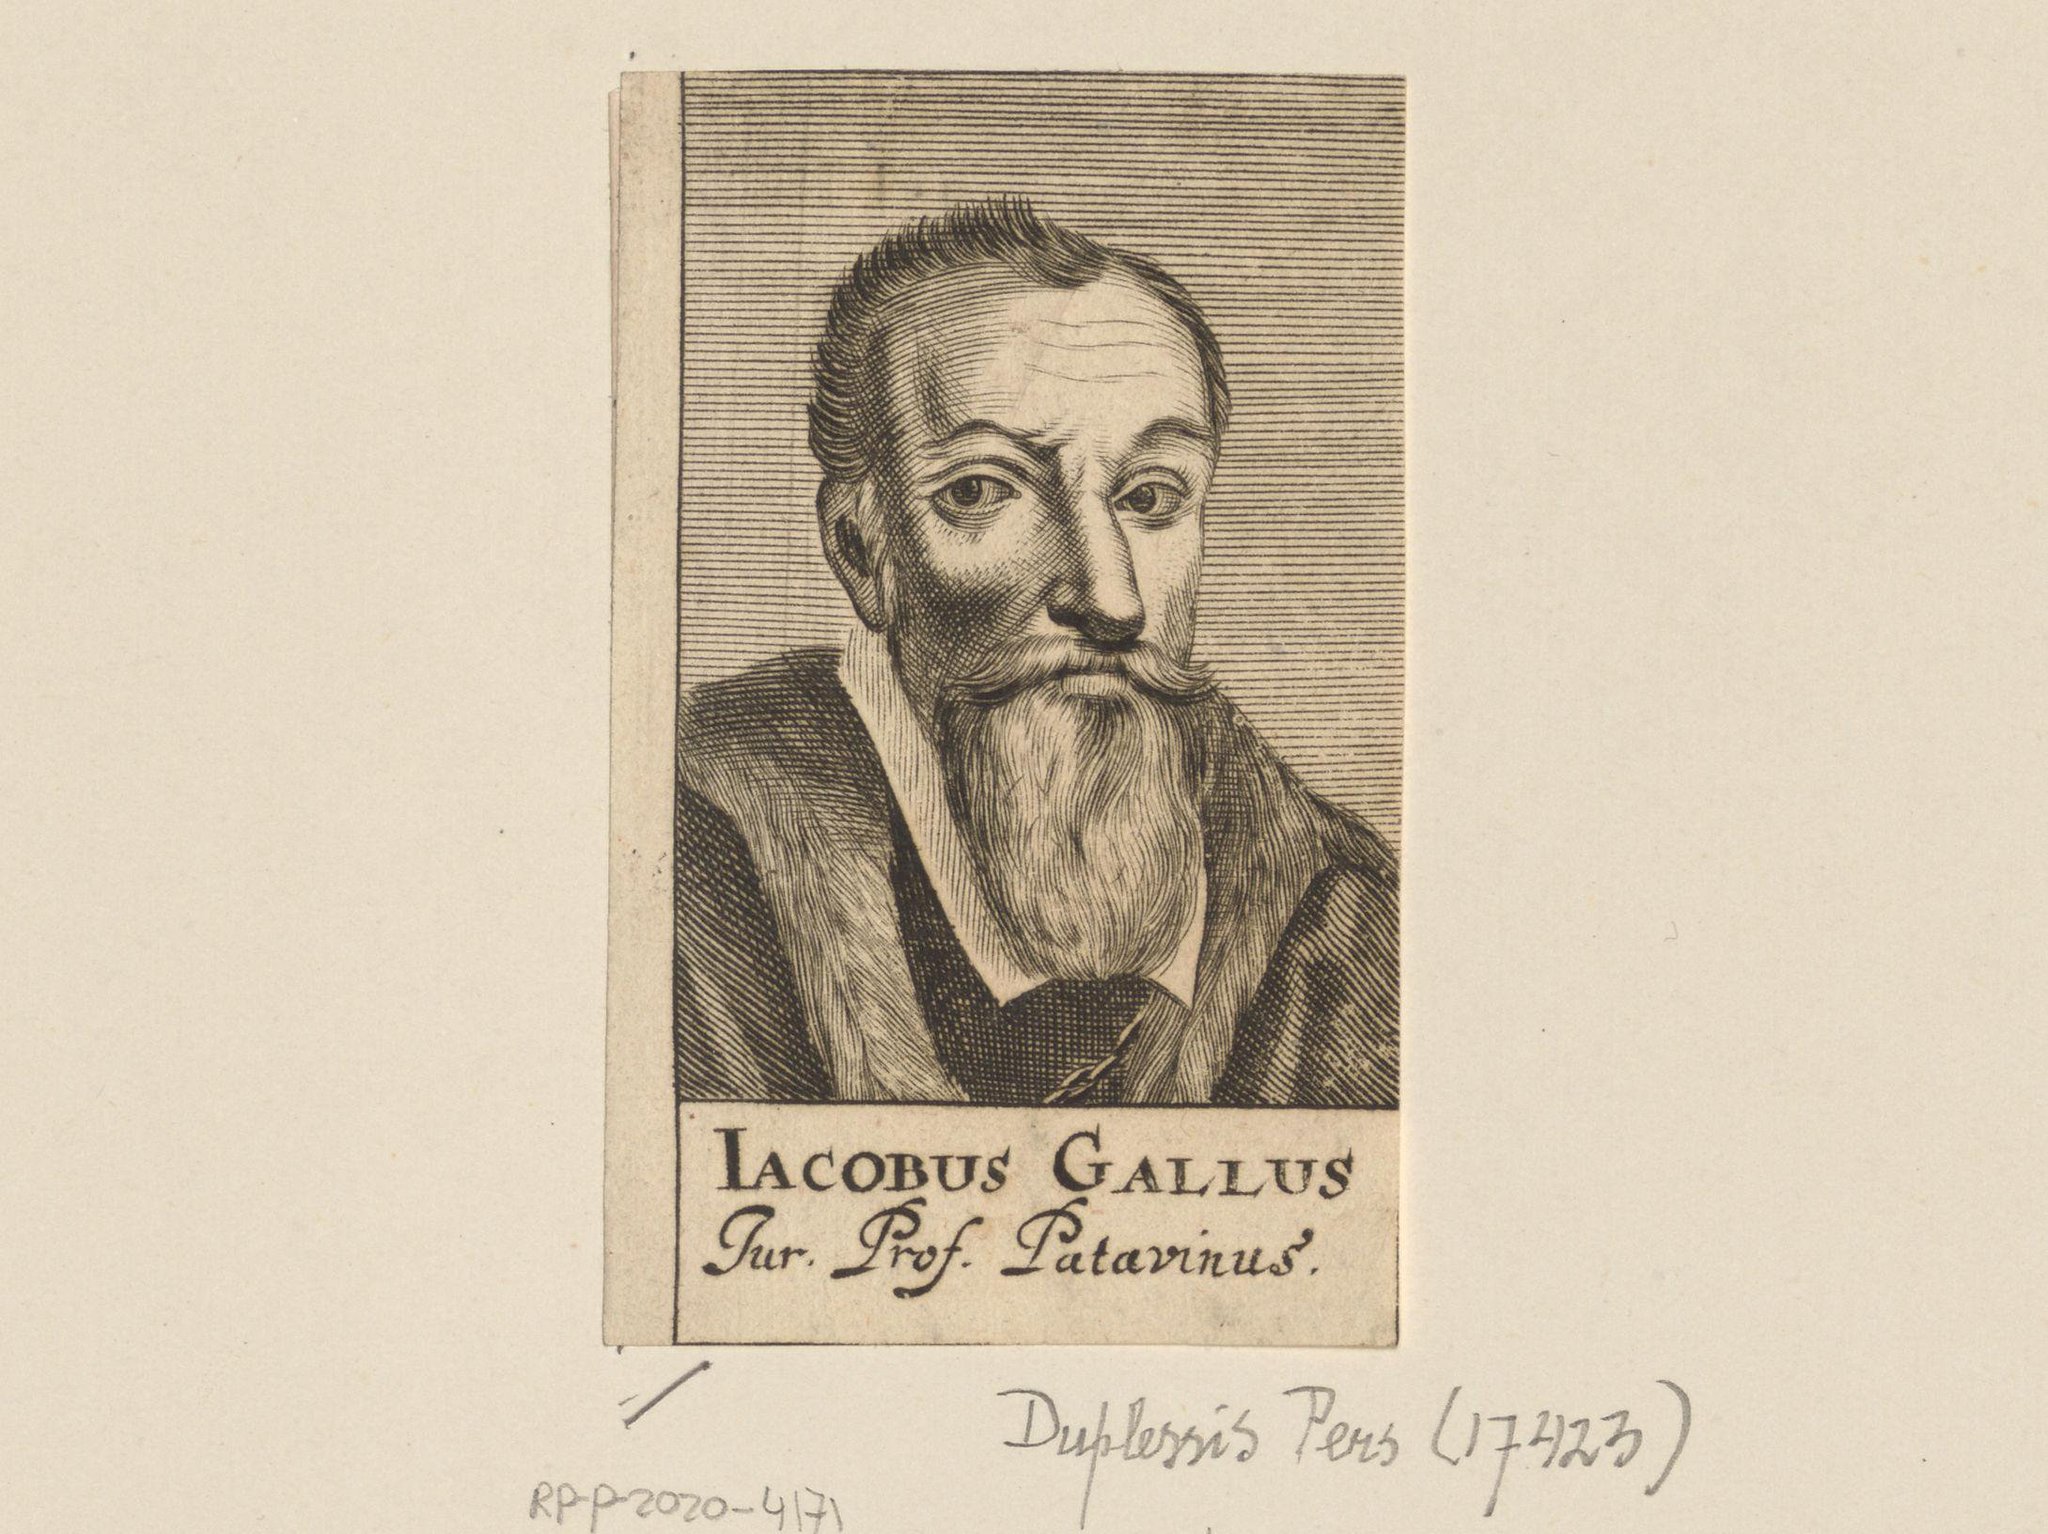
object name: print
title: Portret van Jacobus Gallus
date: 1688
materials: paper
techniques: engraving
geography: nuremberg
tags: historical persons, lawyer, attorney at law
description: Prent uit: Freher, Paul. Theatrum virorum eruditione clarorum. Neurenberg: Johann Hoffmann, 1688.